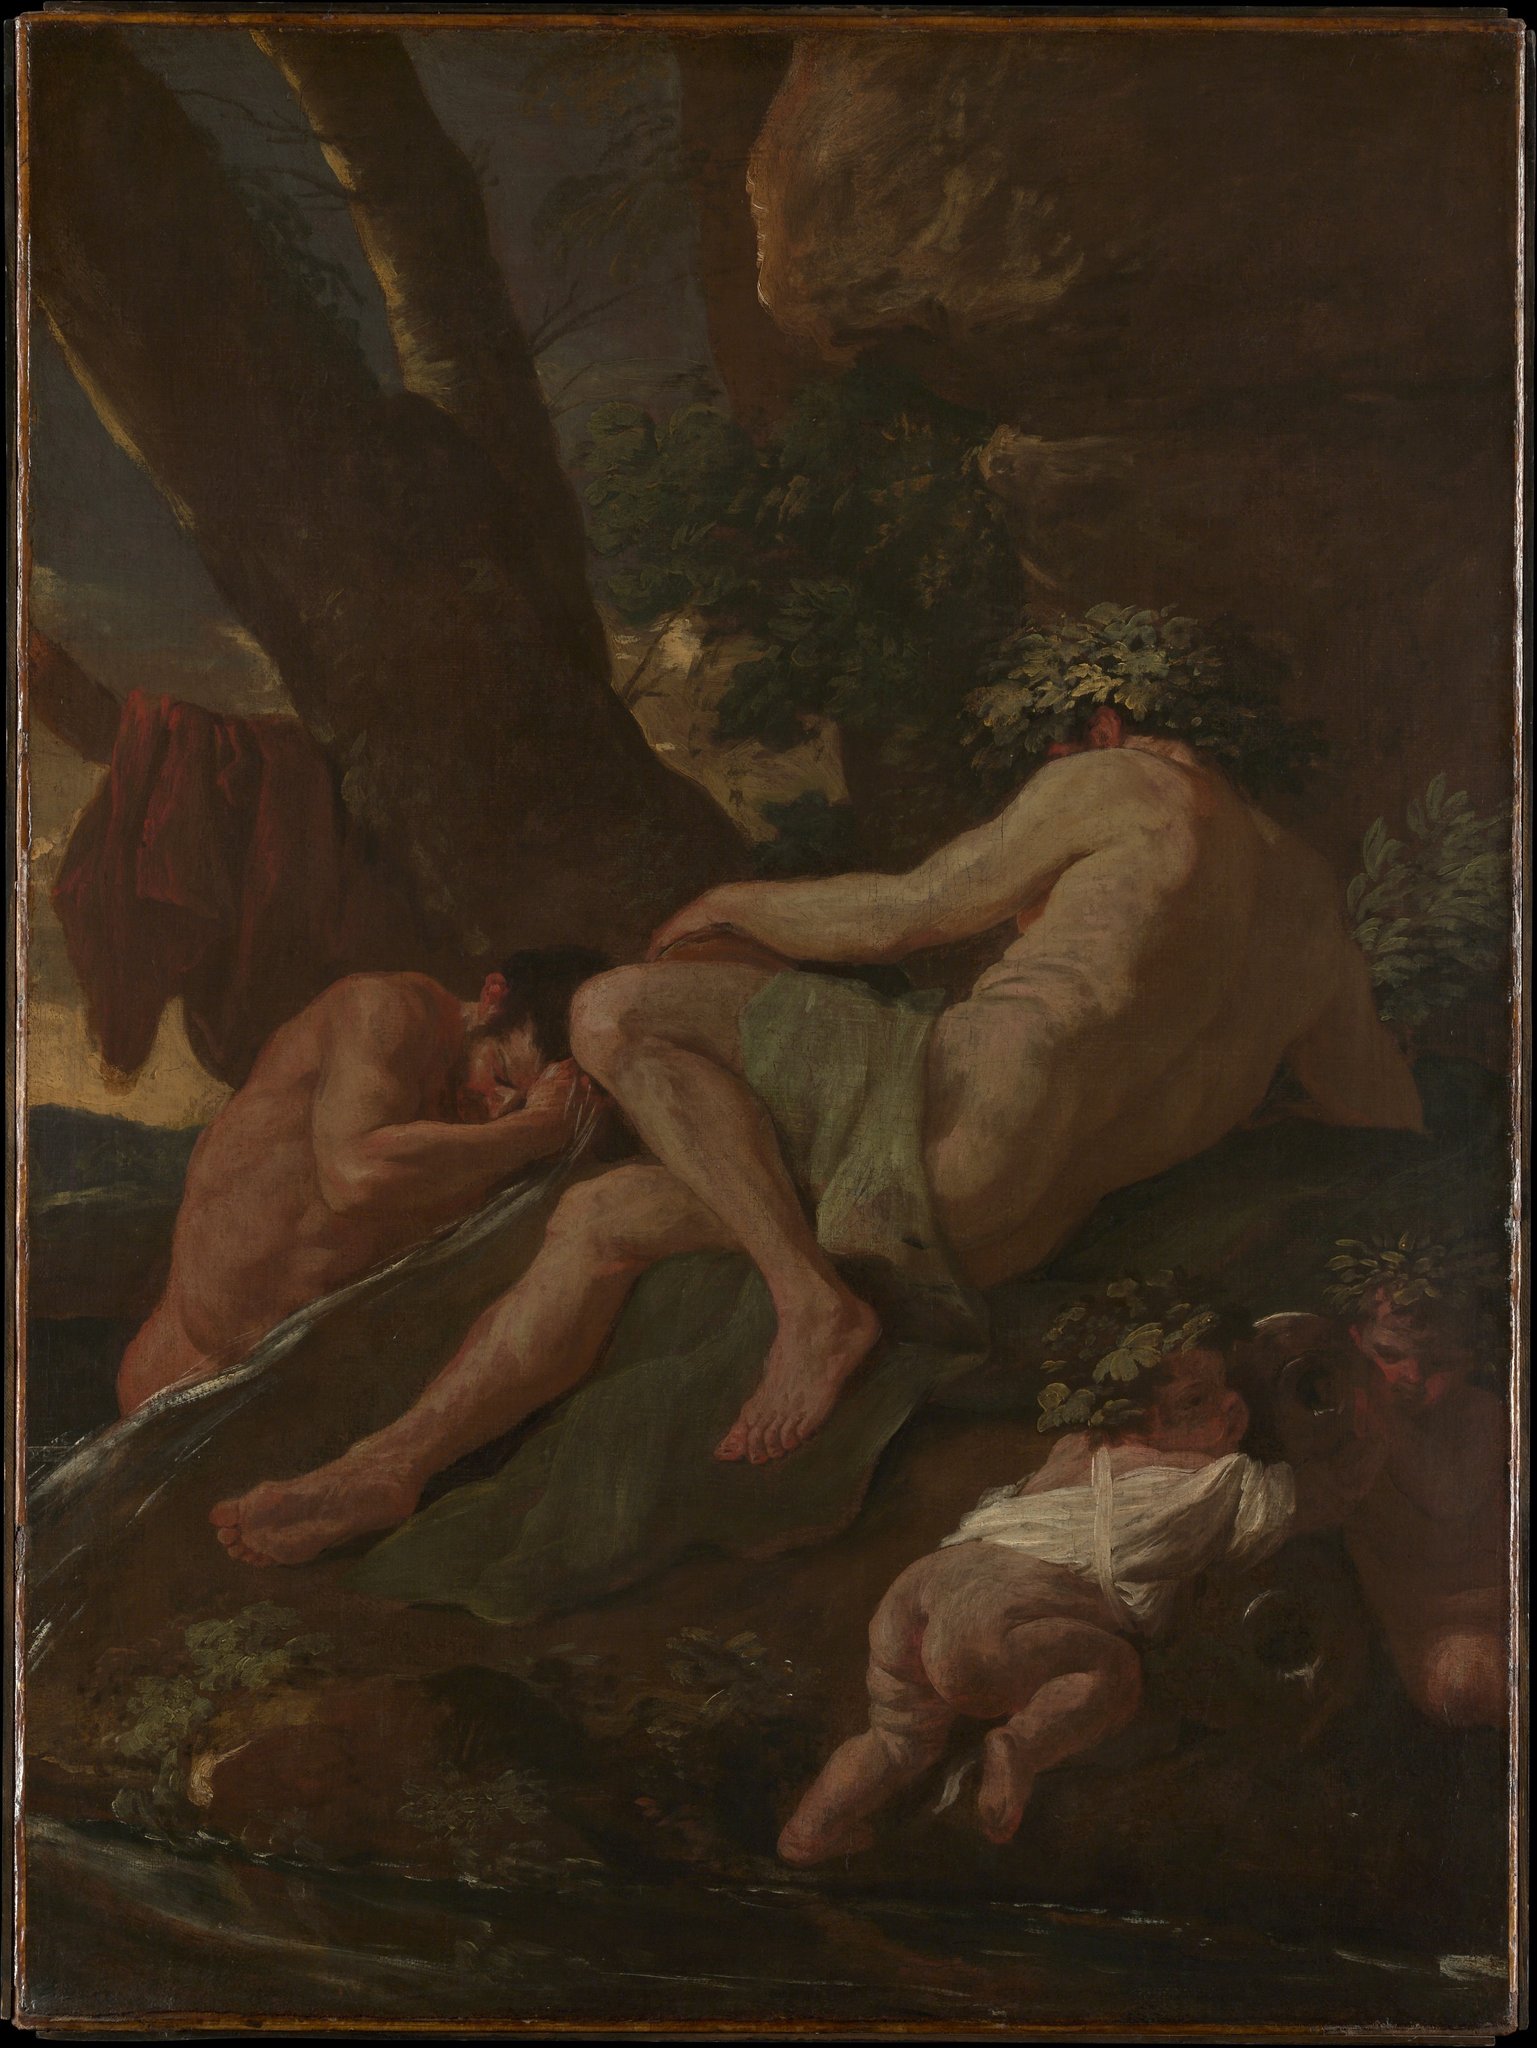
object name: painting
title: Midas Washing at the Source of the Pactolus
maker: nicolas poussin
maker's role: artist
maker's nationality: french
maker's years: 1594-1665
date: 1627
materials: canvas, oil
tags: children,men,midas,rivers